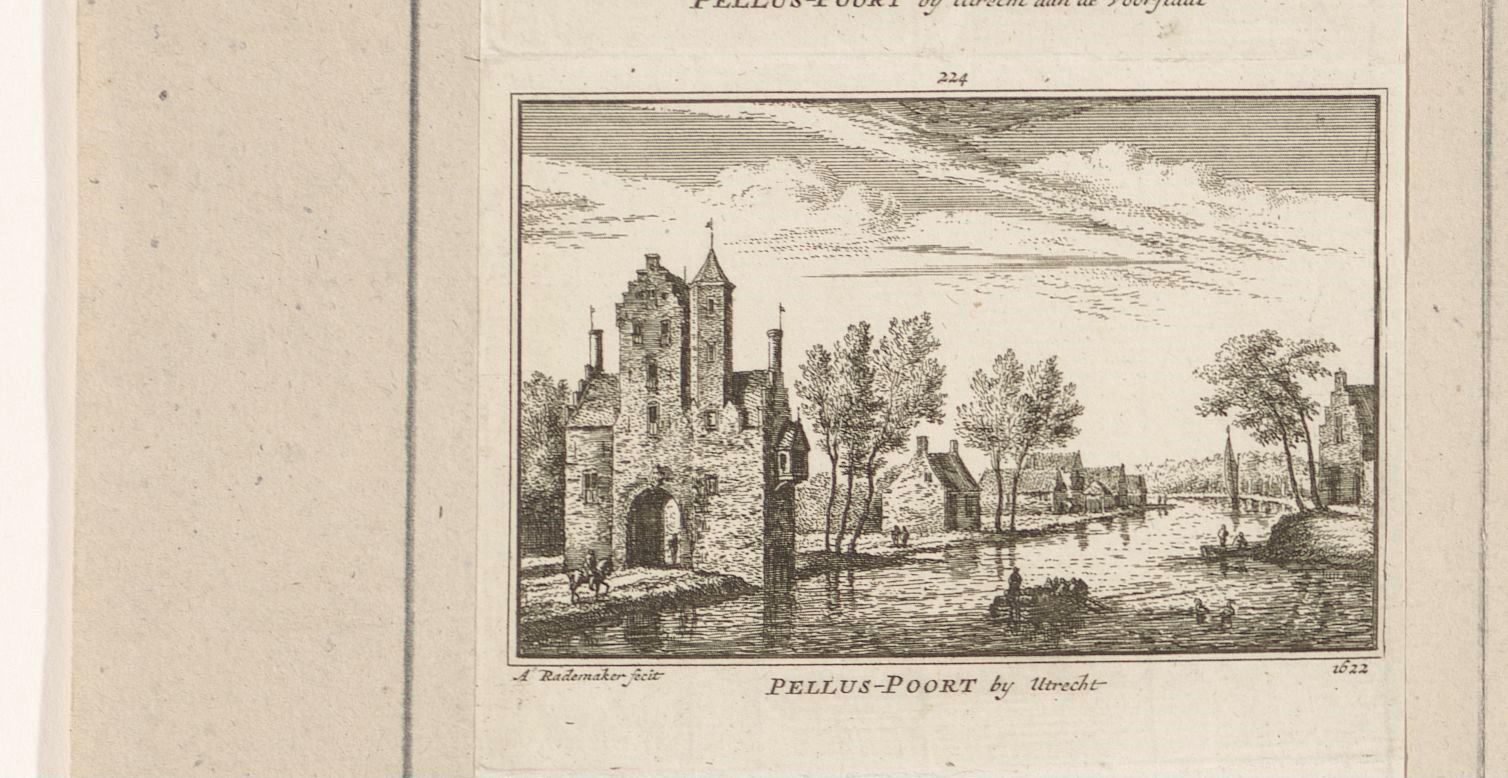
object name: book illustration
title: Pellus-poort by Utrecht 1622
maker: abraham rademaker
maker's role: draughtsman, print maker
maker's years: 1676-1735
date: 1725-1803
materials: paper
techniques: engraving, etching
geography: amsterdam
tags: riding a horse, ass, or mule; rider, horseman, sailing-ship, sailing-boat, gate, entrance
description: Prent ook gebruikt in: Rademaker, Abraham. Kabinet van Nederlandsche outheden en gezichten: vervat in 300 konstplaaten (…). 2 delen. Amsterdam: Willem Barents, 1725, dl. 2, ill. 224. Na 1725 is deze prent nog in verschillende heruitgaven verschenen, uitgegeven in 1727-1733, 1770-1771 en 1792-1803. Uit welke uitgave het huidige exemplaar precies komt is niet na te gaan.